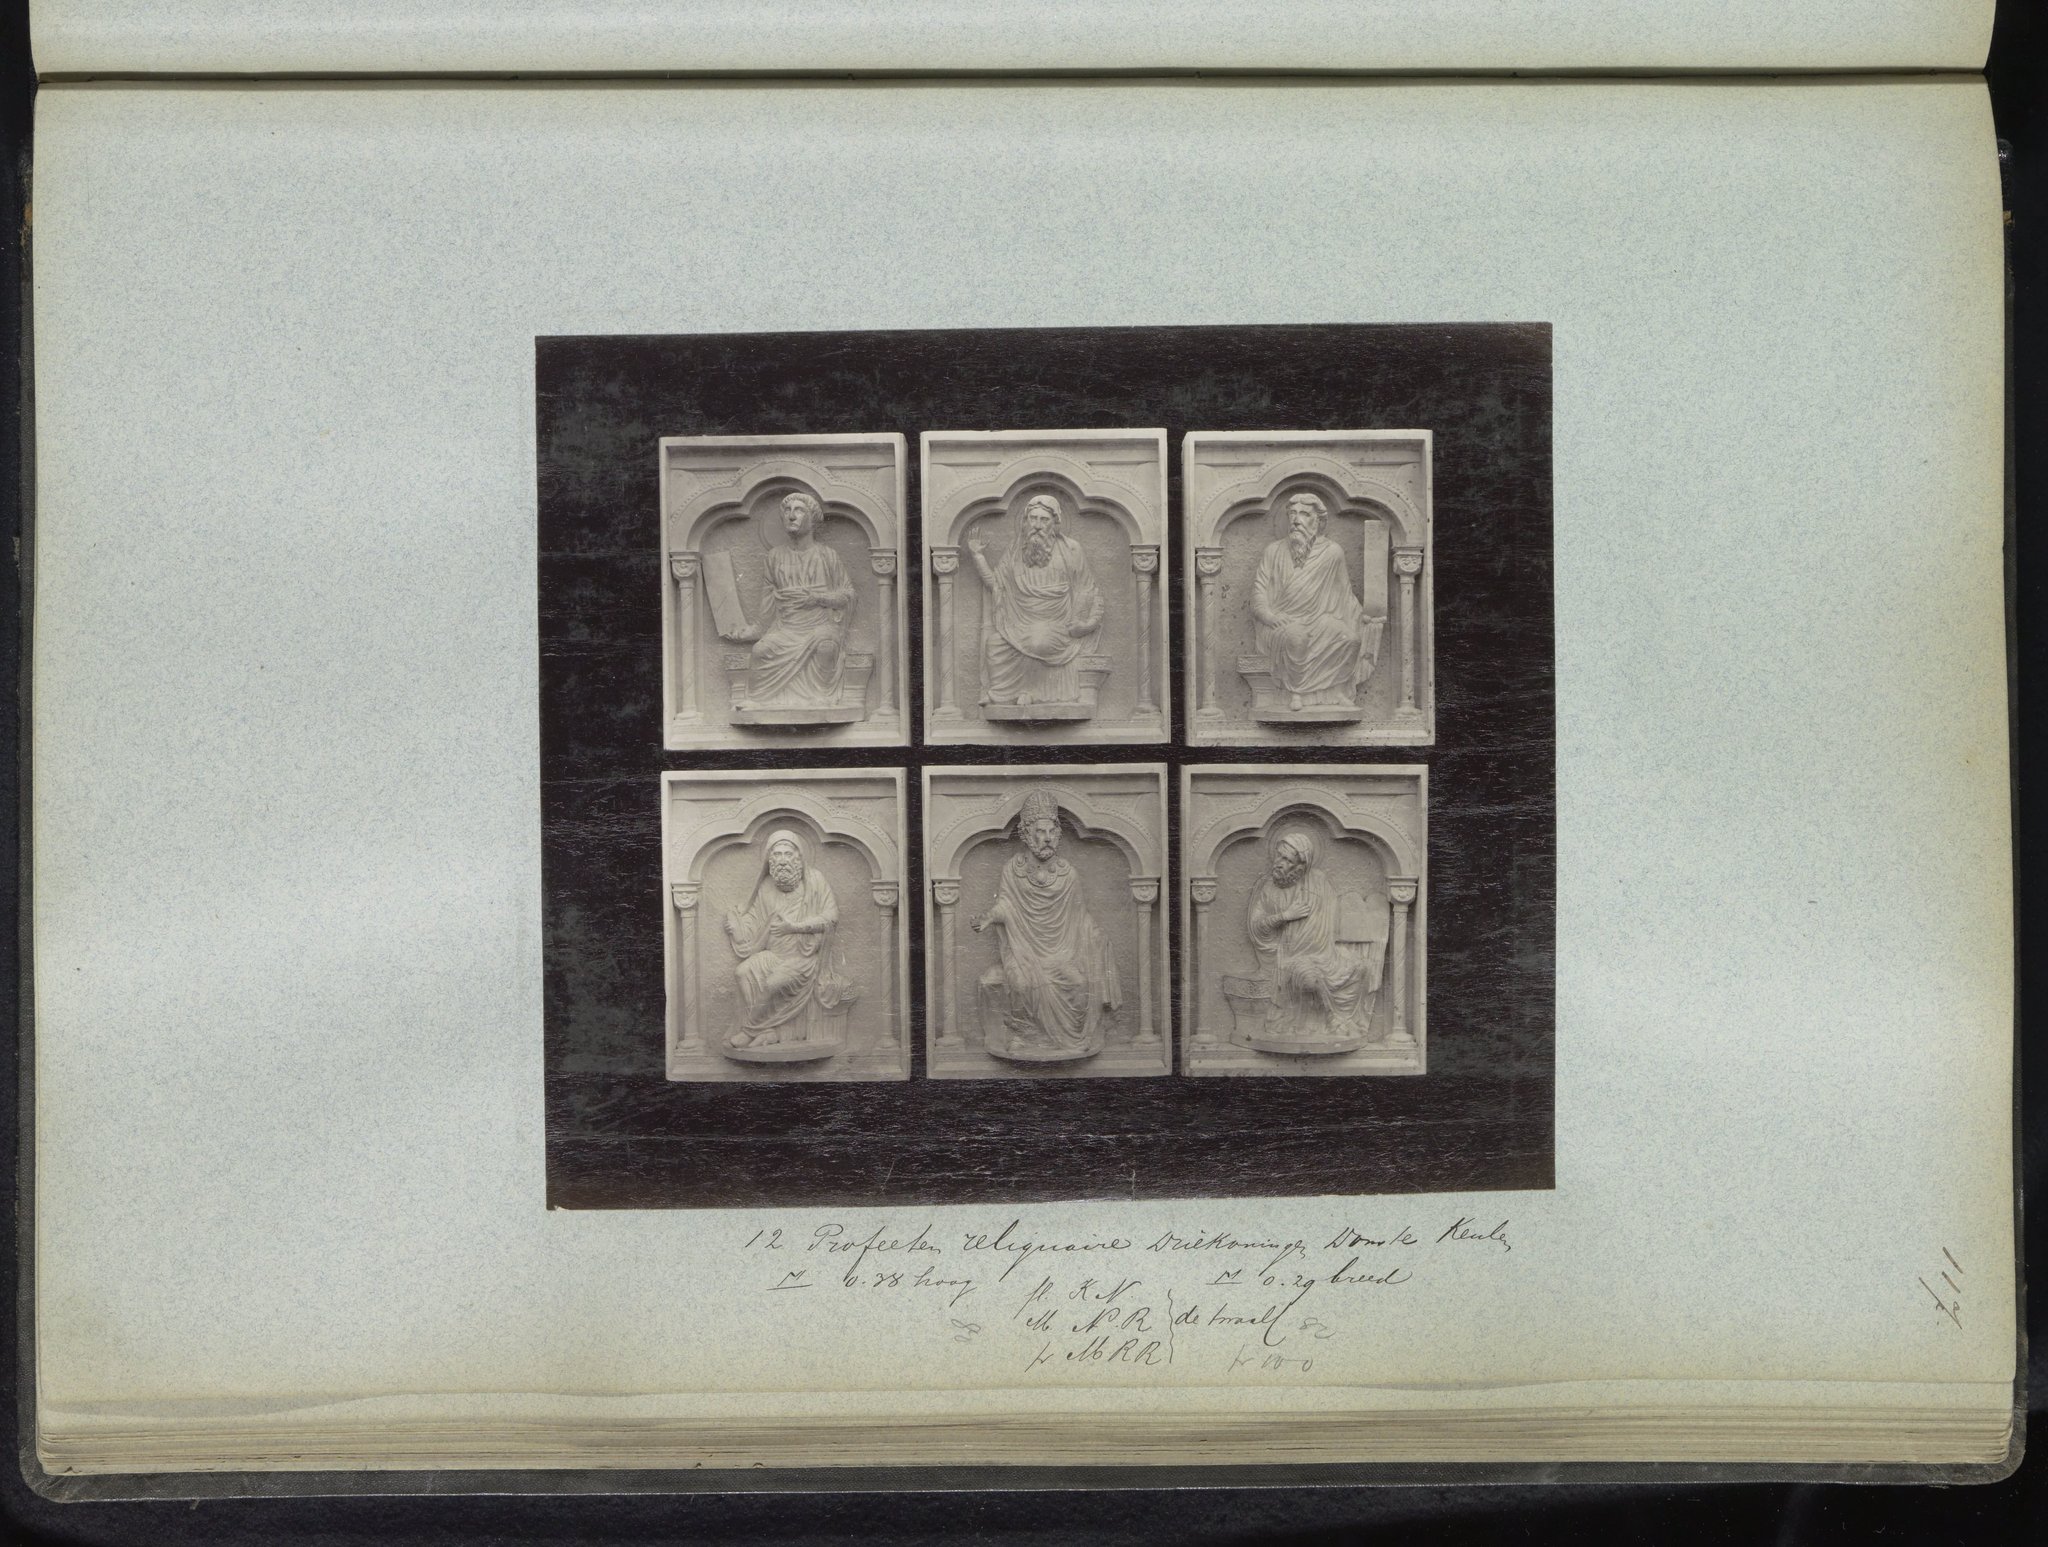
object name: album leaf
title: Zes gipsen afgietsels van panelen van profeten van het reliekschrijn van de Drie Koningen uit de Dom van Keulen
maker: Anonymous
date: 1875-1900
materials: paper, photographic support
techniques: albumen print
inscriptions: annotation, annotation: ‘12 Profeeten reliquarie Driekoningen Dom te Keulen / M 0.38 hoog M 0.29 breed’